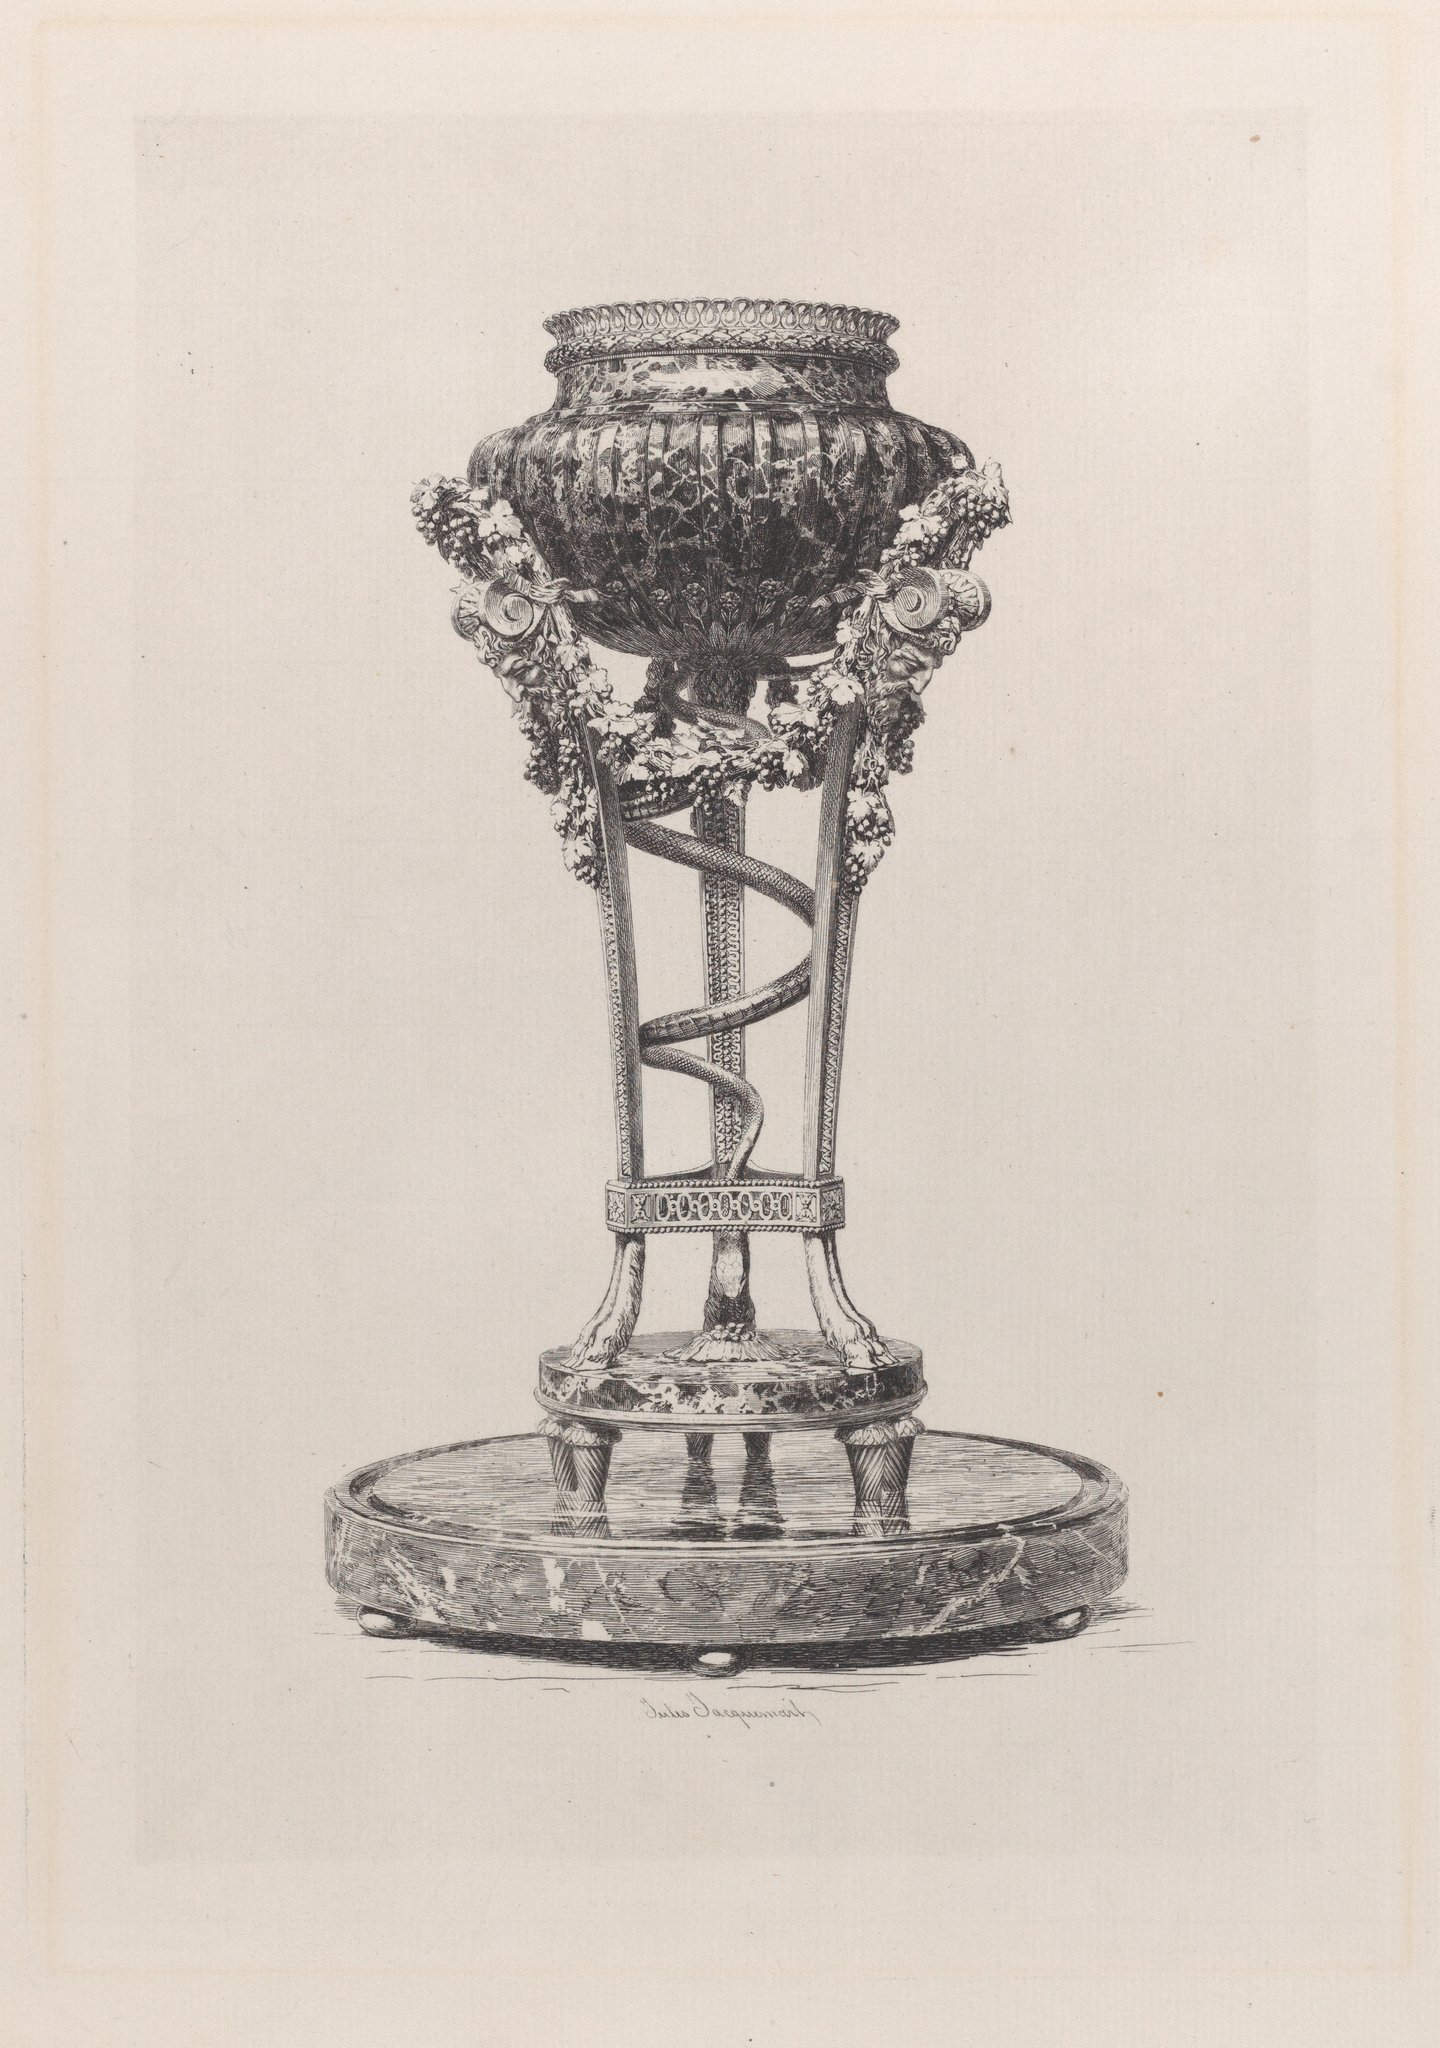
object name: print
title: Trépied par Gouthières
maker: jules-ferdinand jacquemart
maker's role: artist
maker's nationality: french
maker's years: 1837-1880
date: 1866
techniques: etching